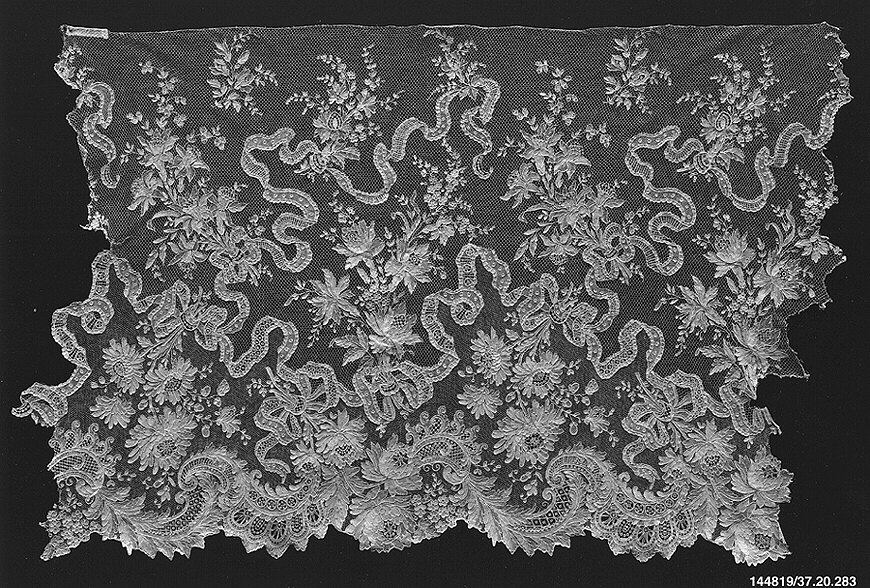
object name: flounce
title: Flounce (one of a pair)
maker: georges martin (compagnie des indes)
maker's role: maker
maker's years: 1800-1900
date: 1801-1900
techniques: lace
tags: flowers